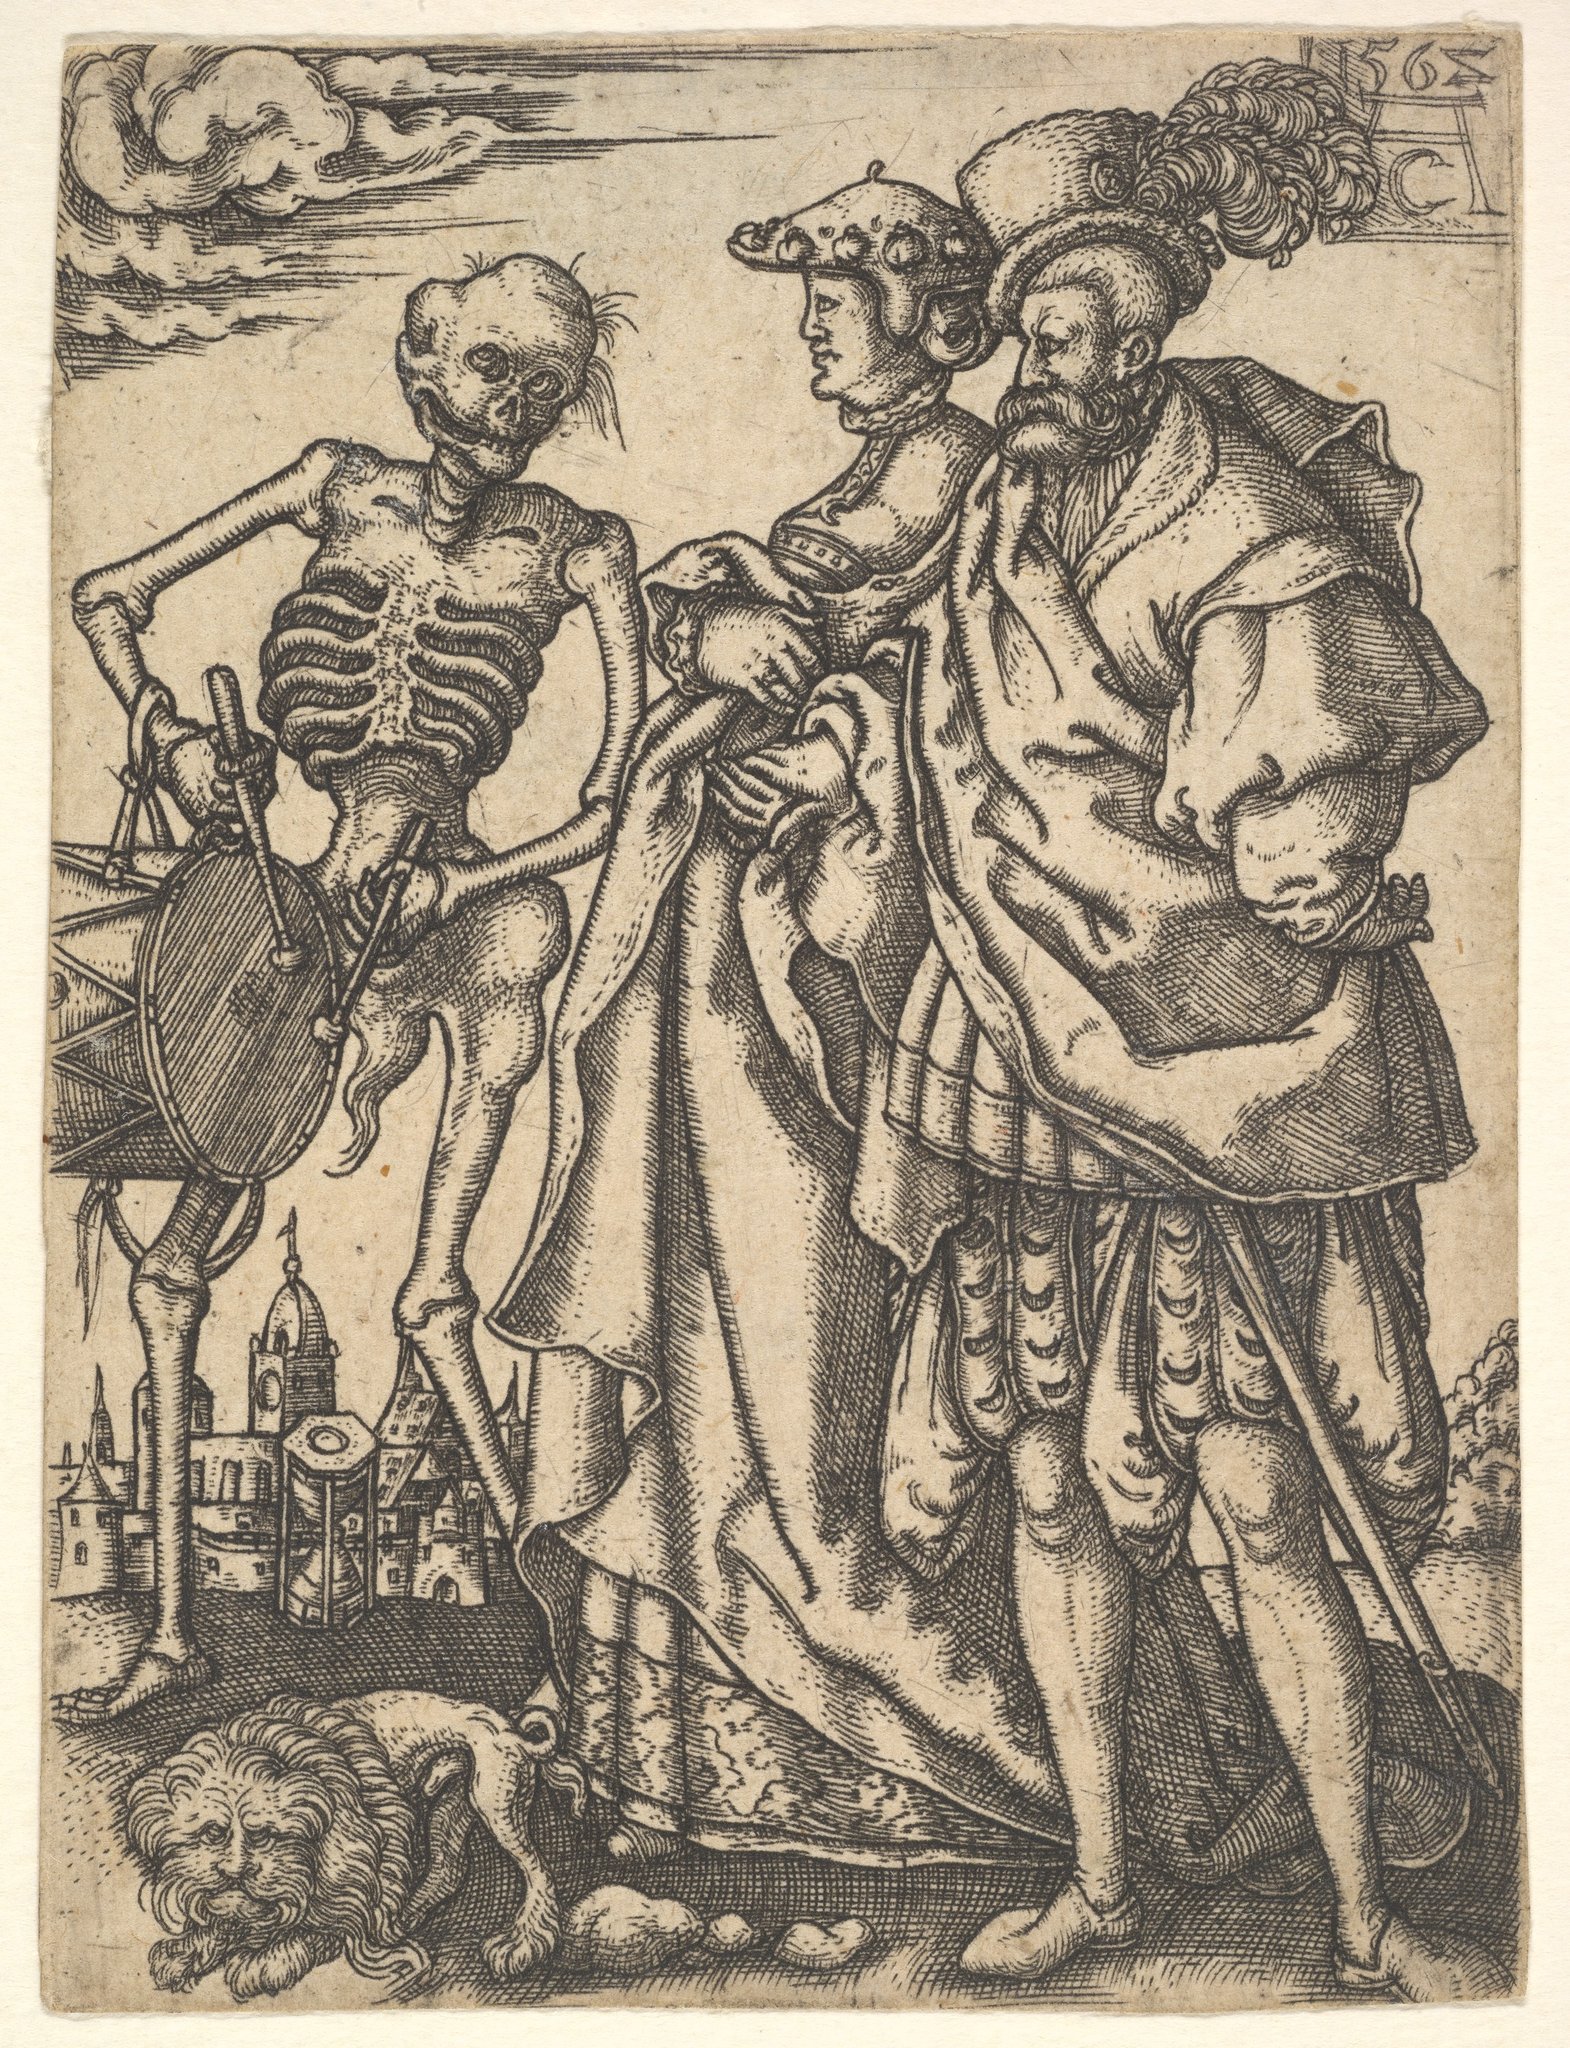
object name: print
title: Couple and Death with a Drum, from "The Dance of Death"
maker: allaert claesz.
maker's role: artist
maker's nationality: dutch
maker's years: 1520-1555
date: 1520-1555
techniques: engraving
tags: skeletons,couples,men,women,drums,lions,death